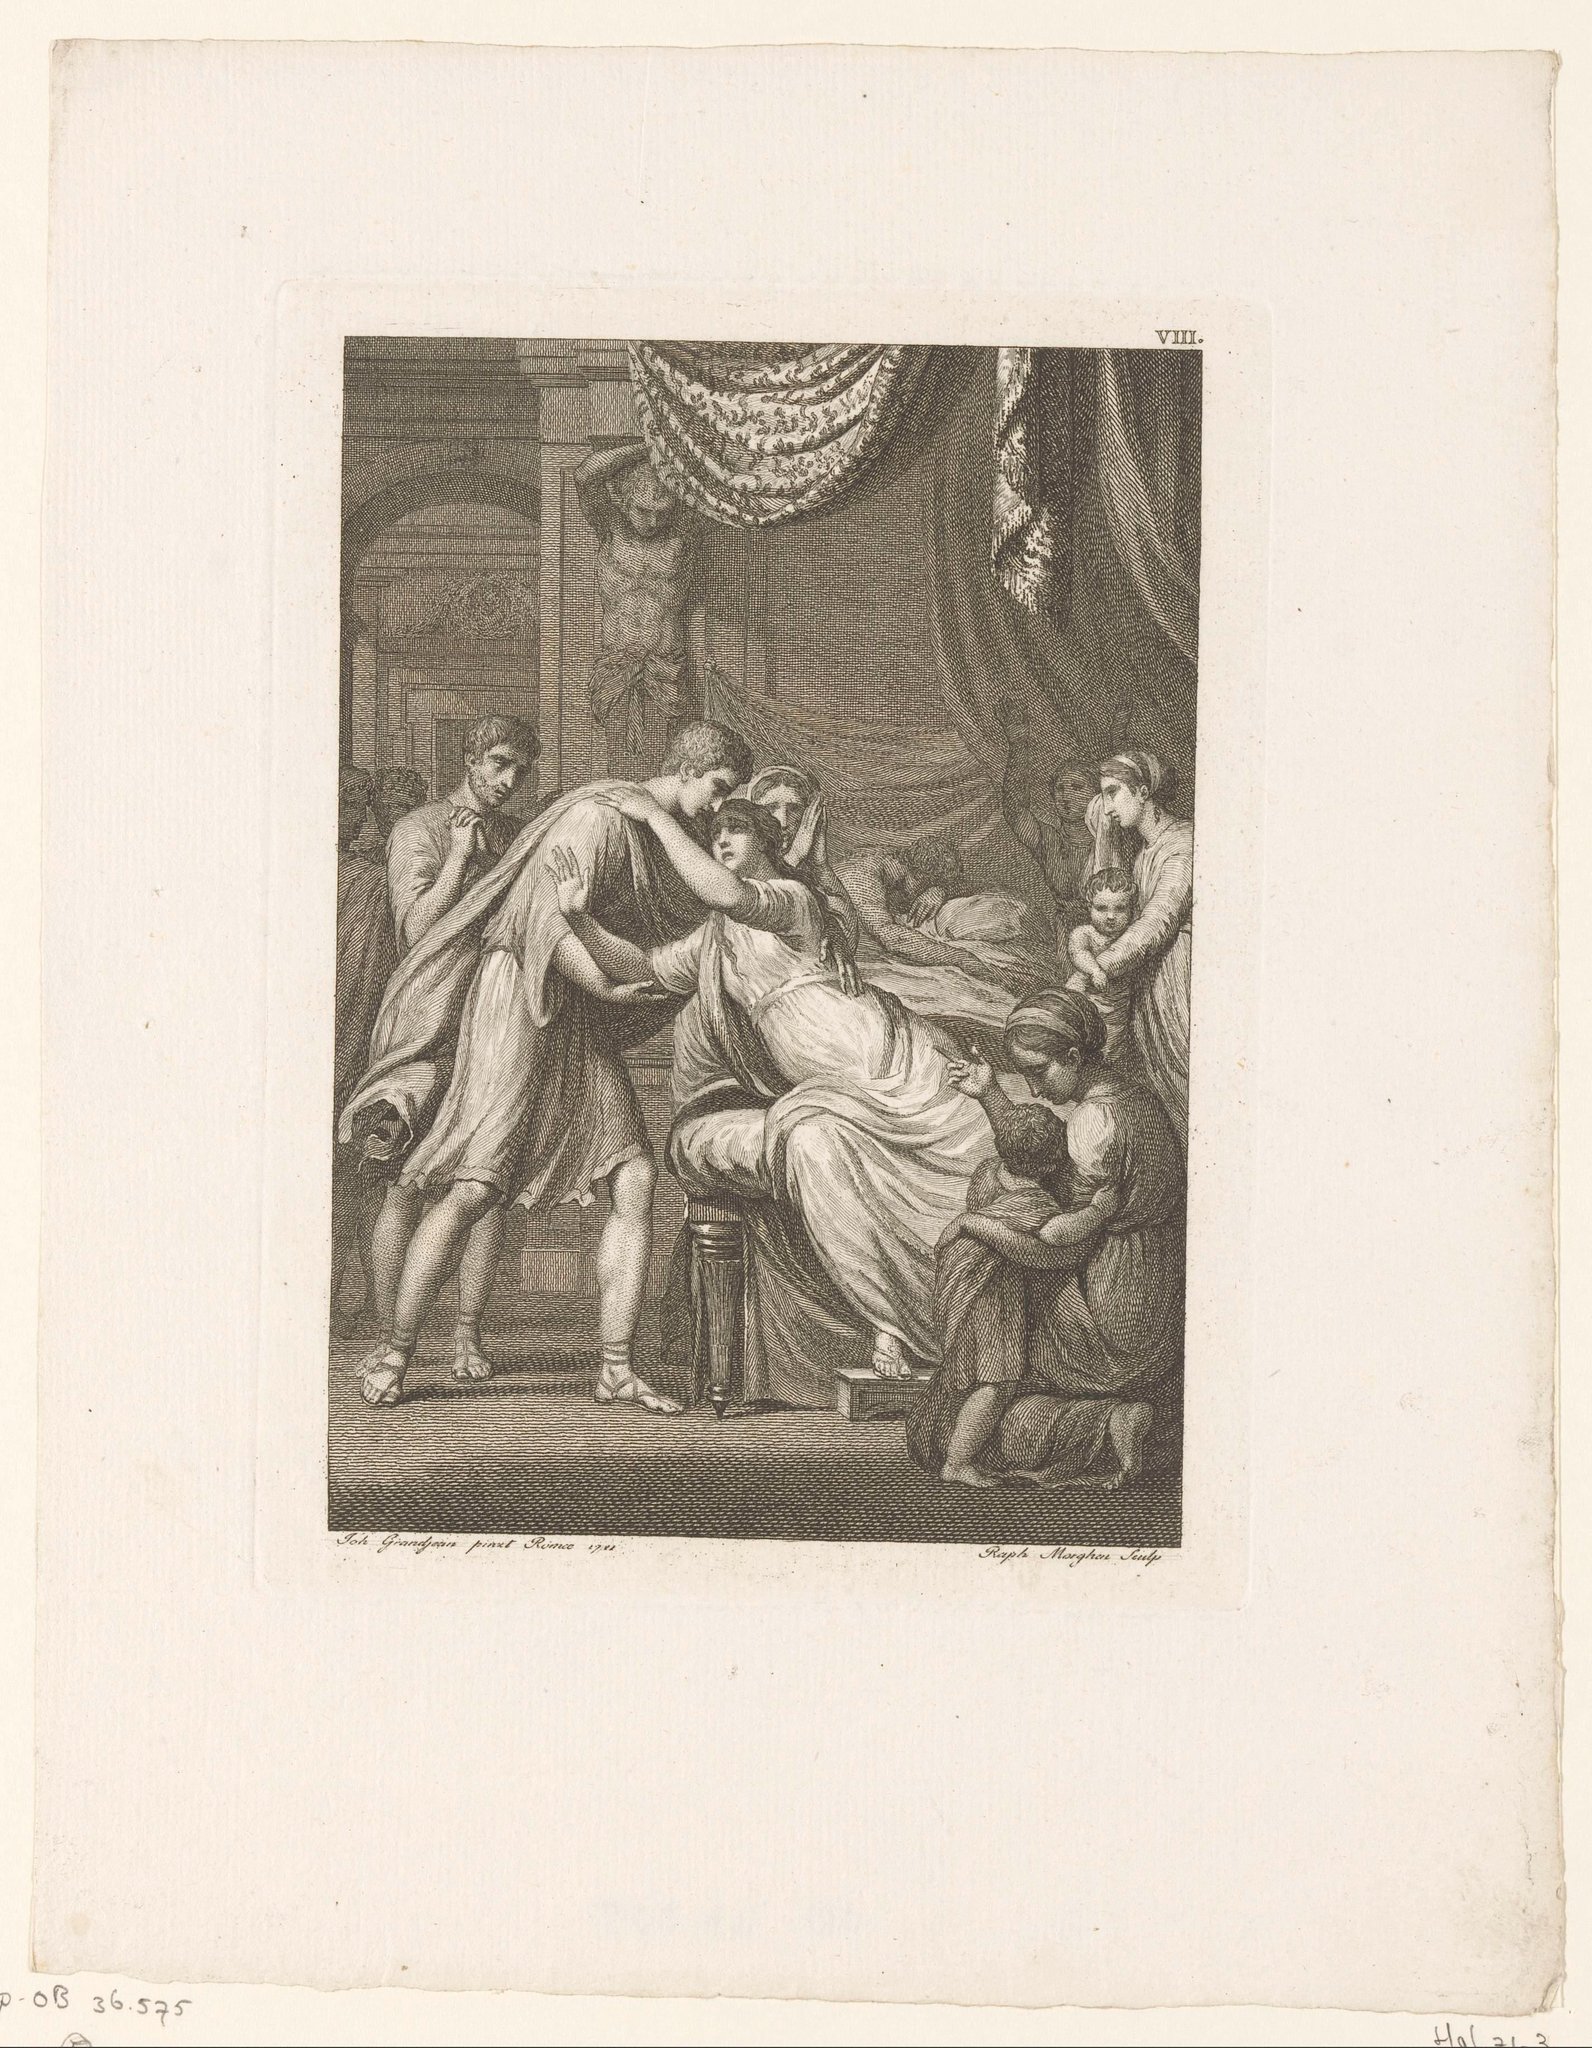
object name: history print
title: Germanicus neemt afscheid van Agrippina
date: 1779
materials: paper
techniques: etching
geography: amsterdam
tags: (story of) agrippina the elder, (story of) germanicus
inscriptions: collector's mark: Lugt 2228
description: Germanicus neemt afscheid van Agrippina. Naast Agrippina staan en knielen vrouwen met kinderen rond haar bed. Genummerd rechtsboven: VIII.